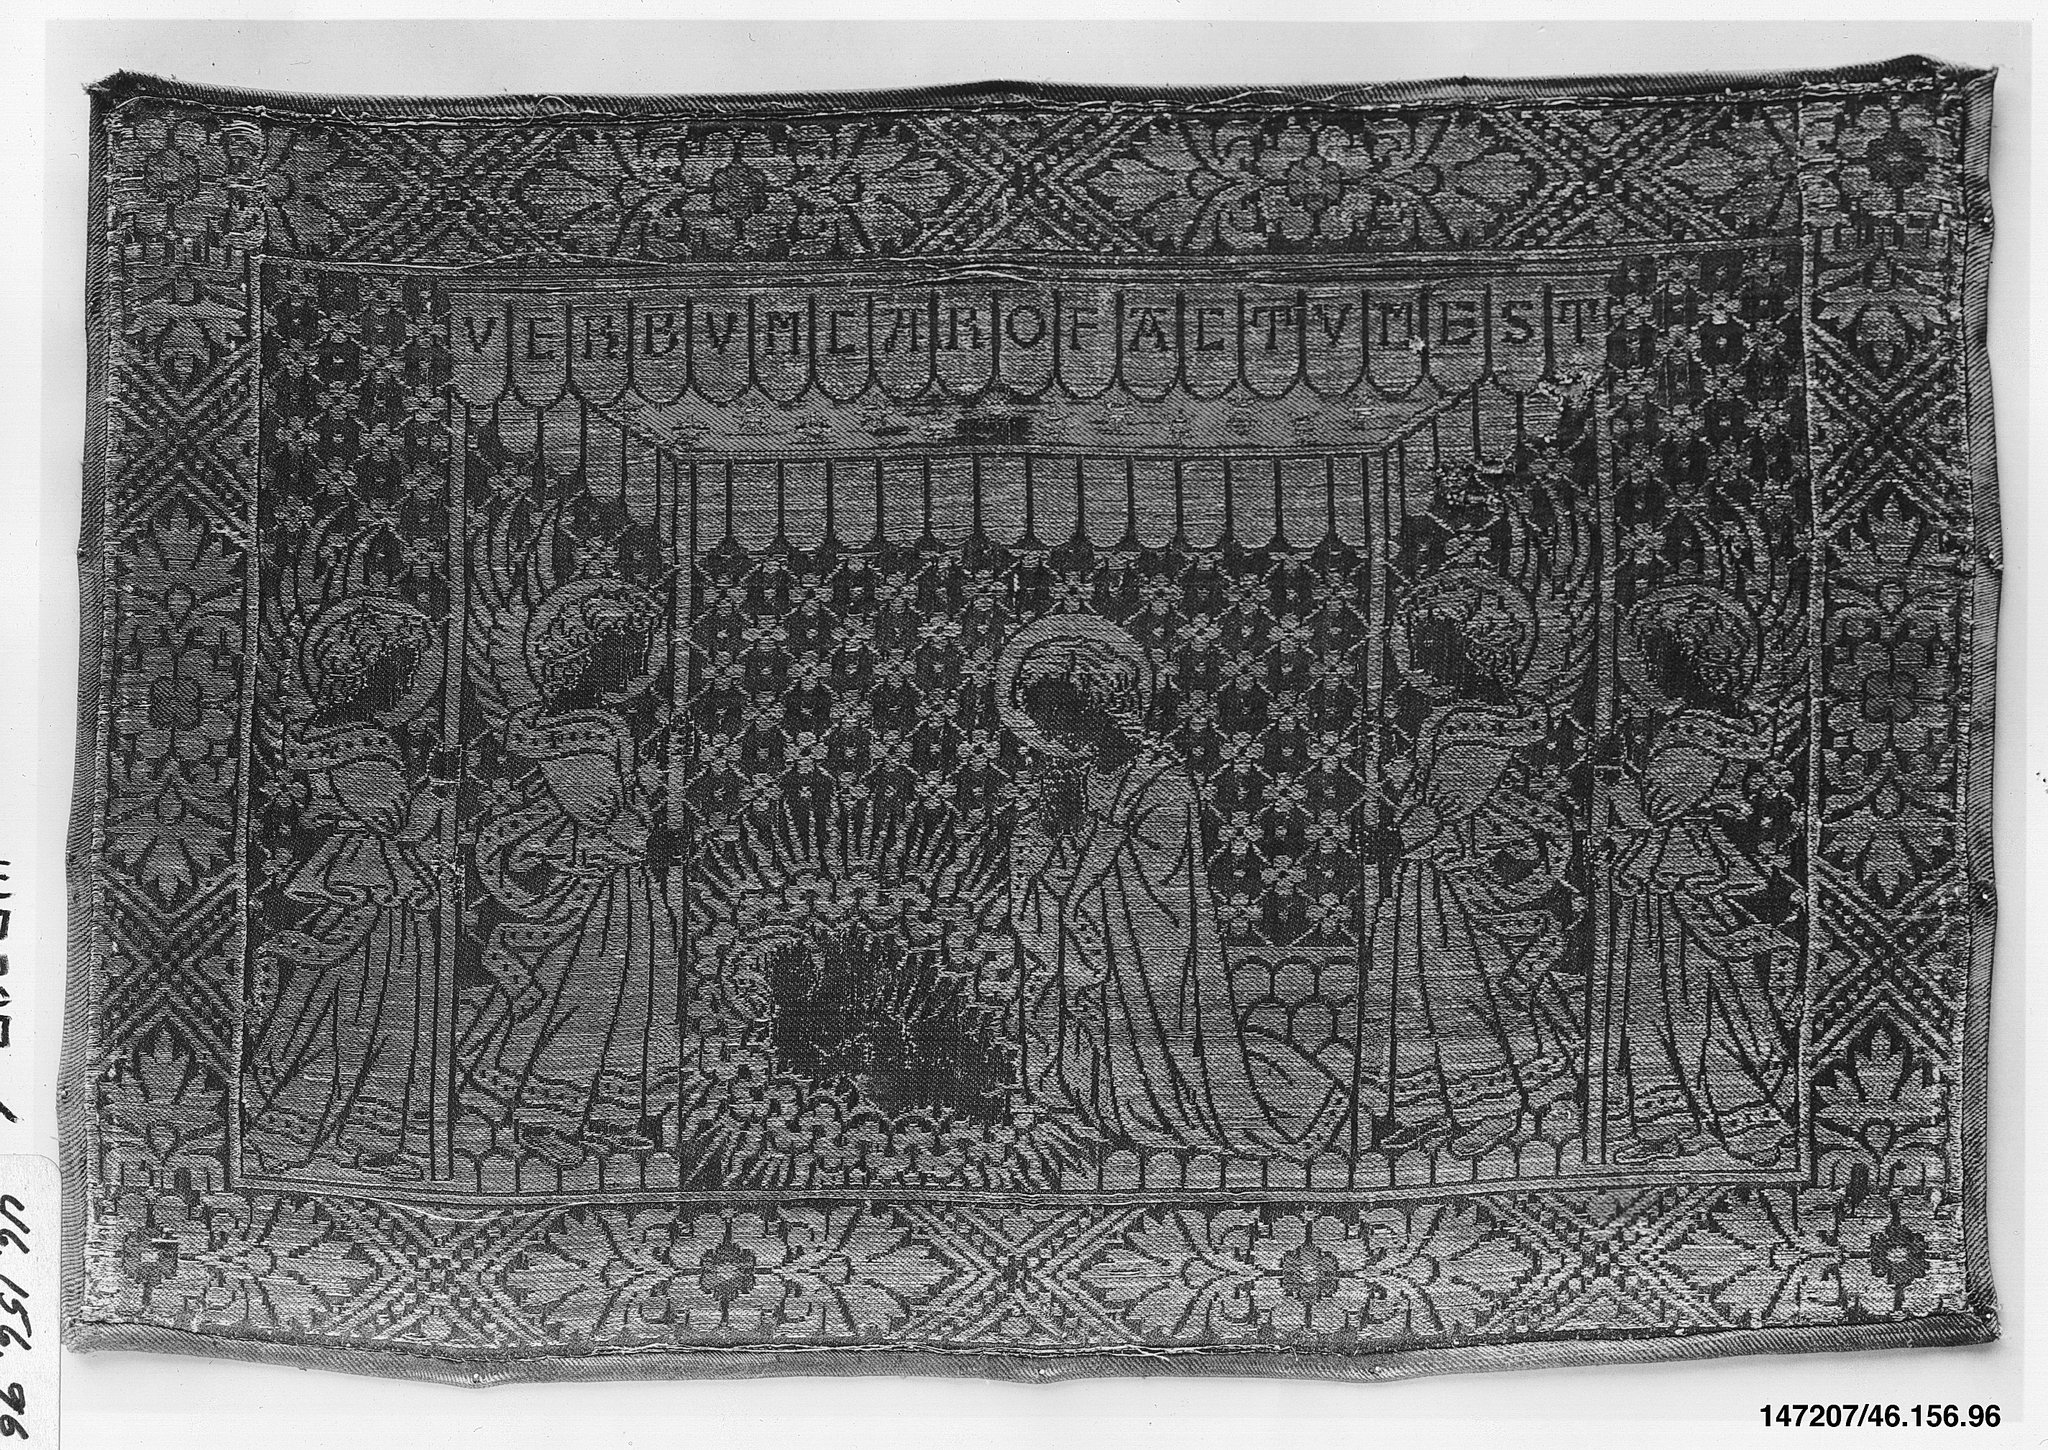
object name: orphrey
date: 1467-1533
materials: silk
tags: angels,jesus